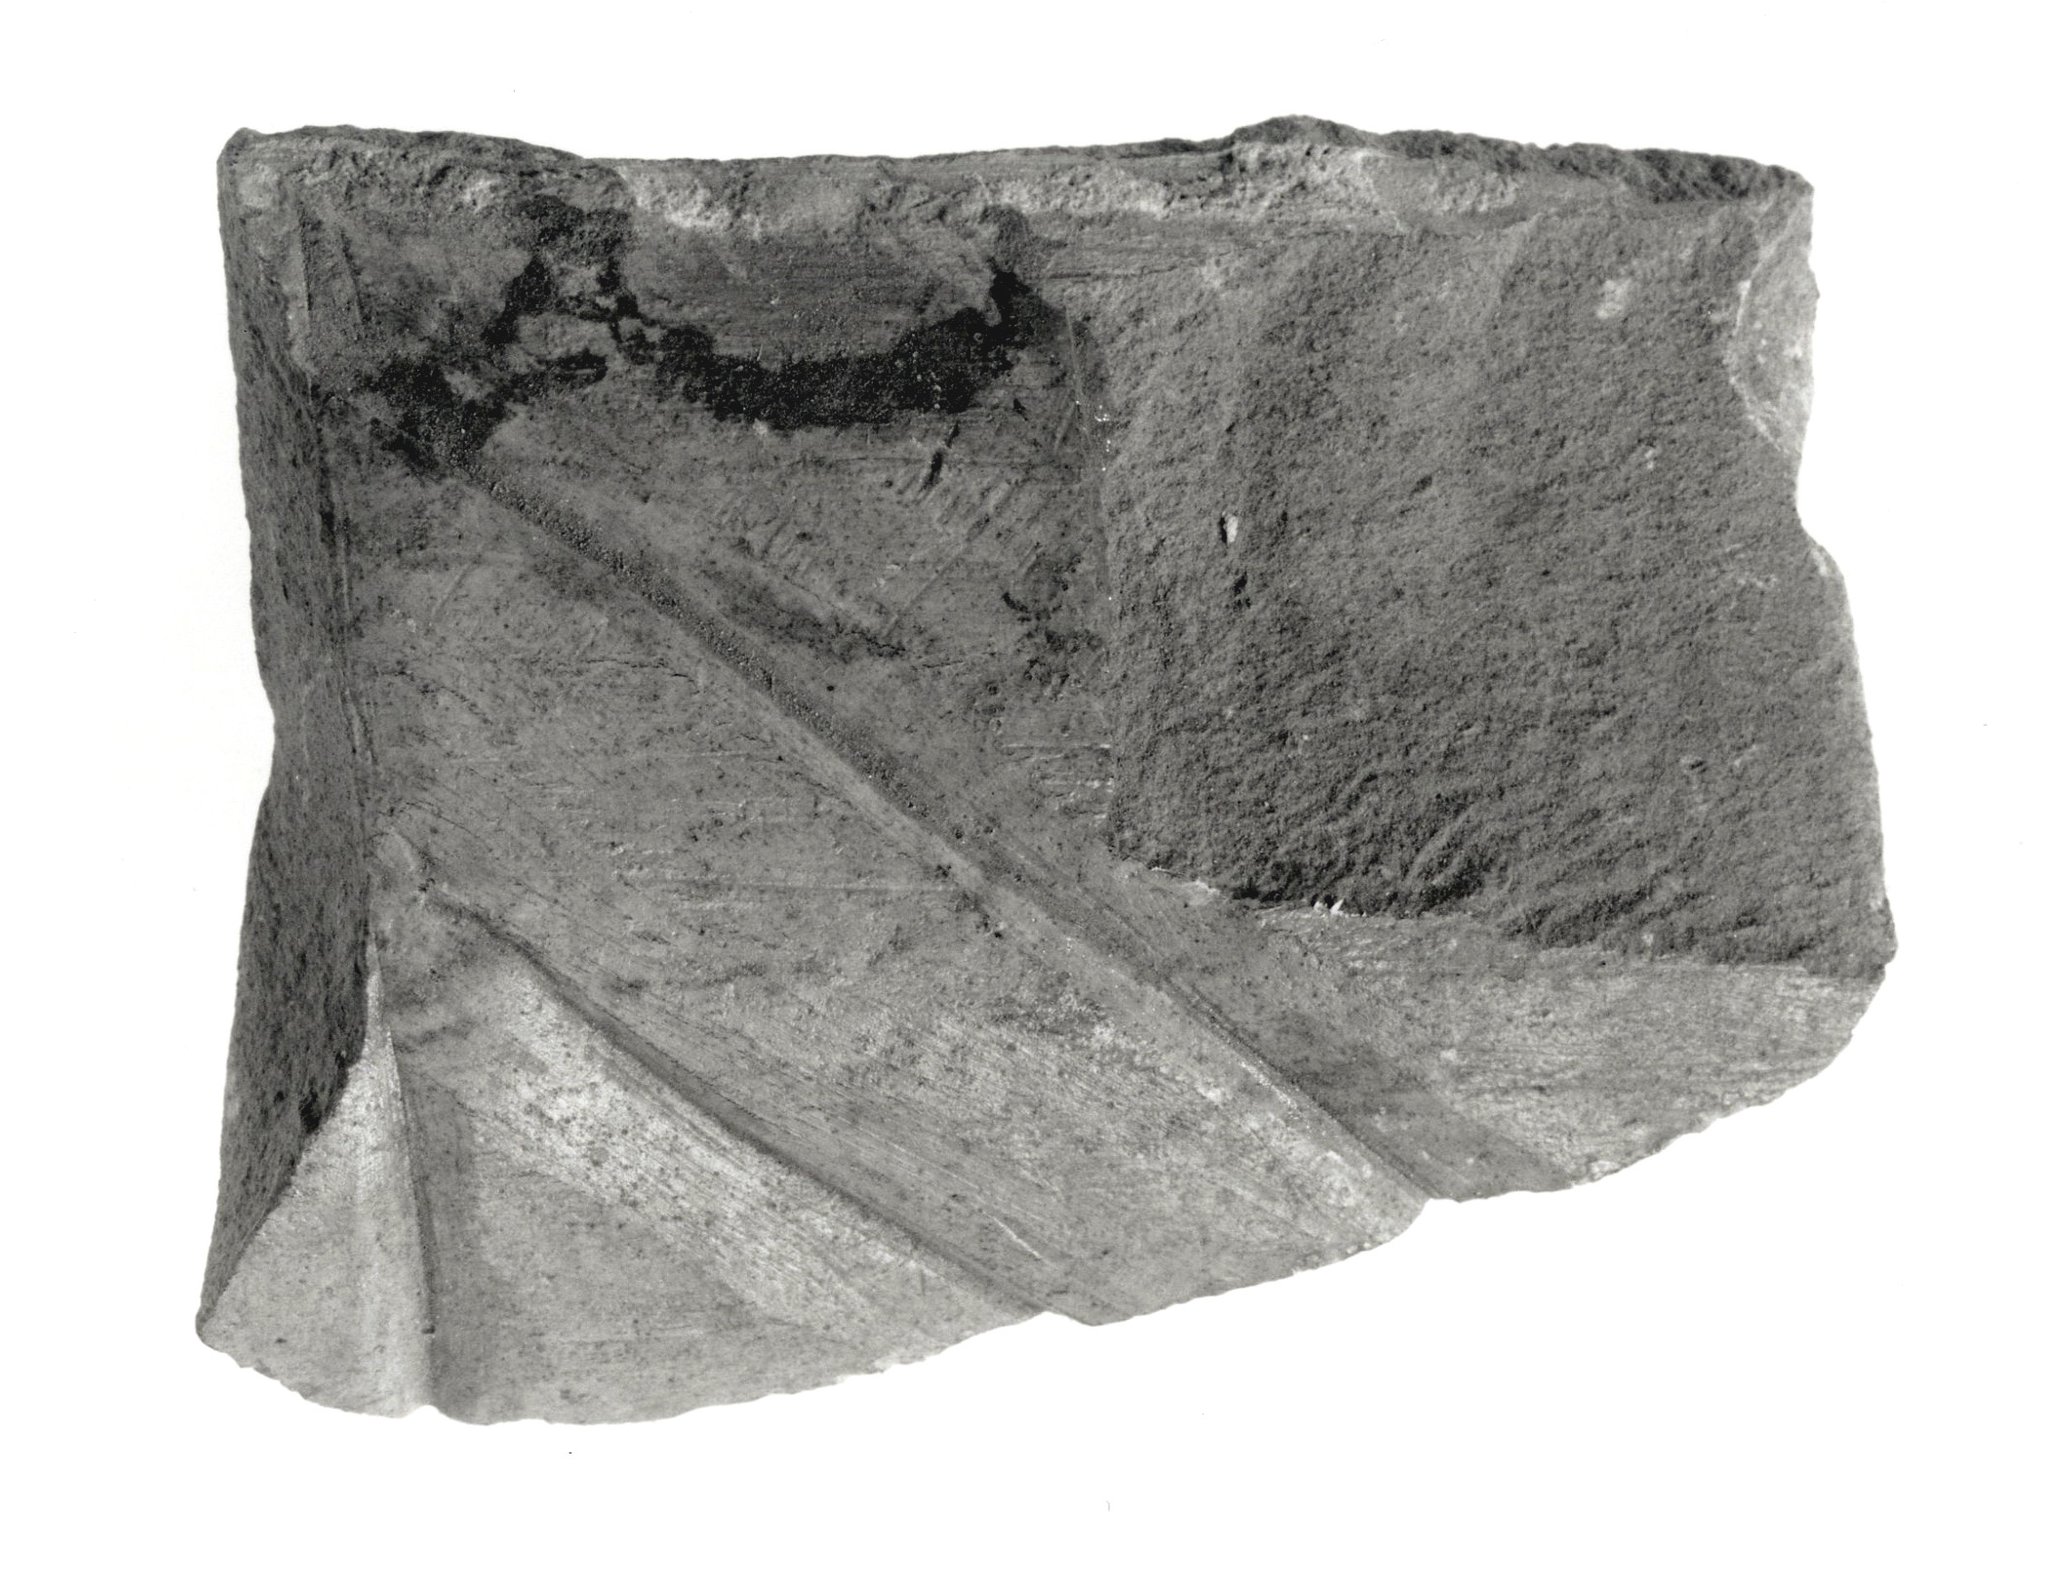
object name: relief, tomb of nespekashuty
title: Raised relief fragment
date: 664-610 BCE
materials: limestone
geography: egypt